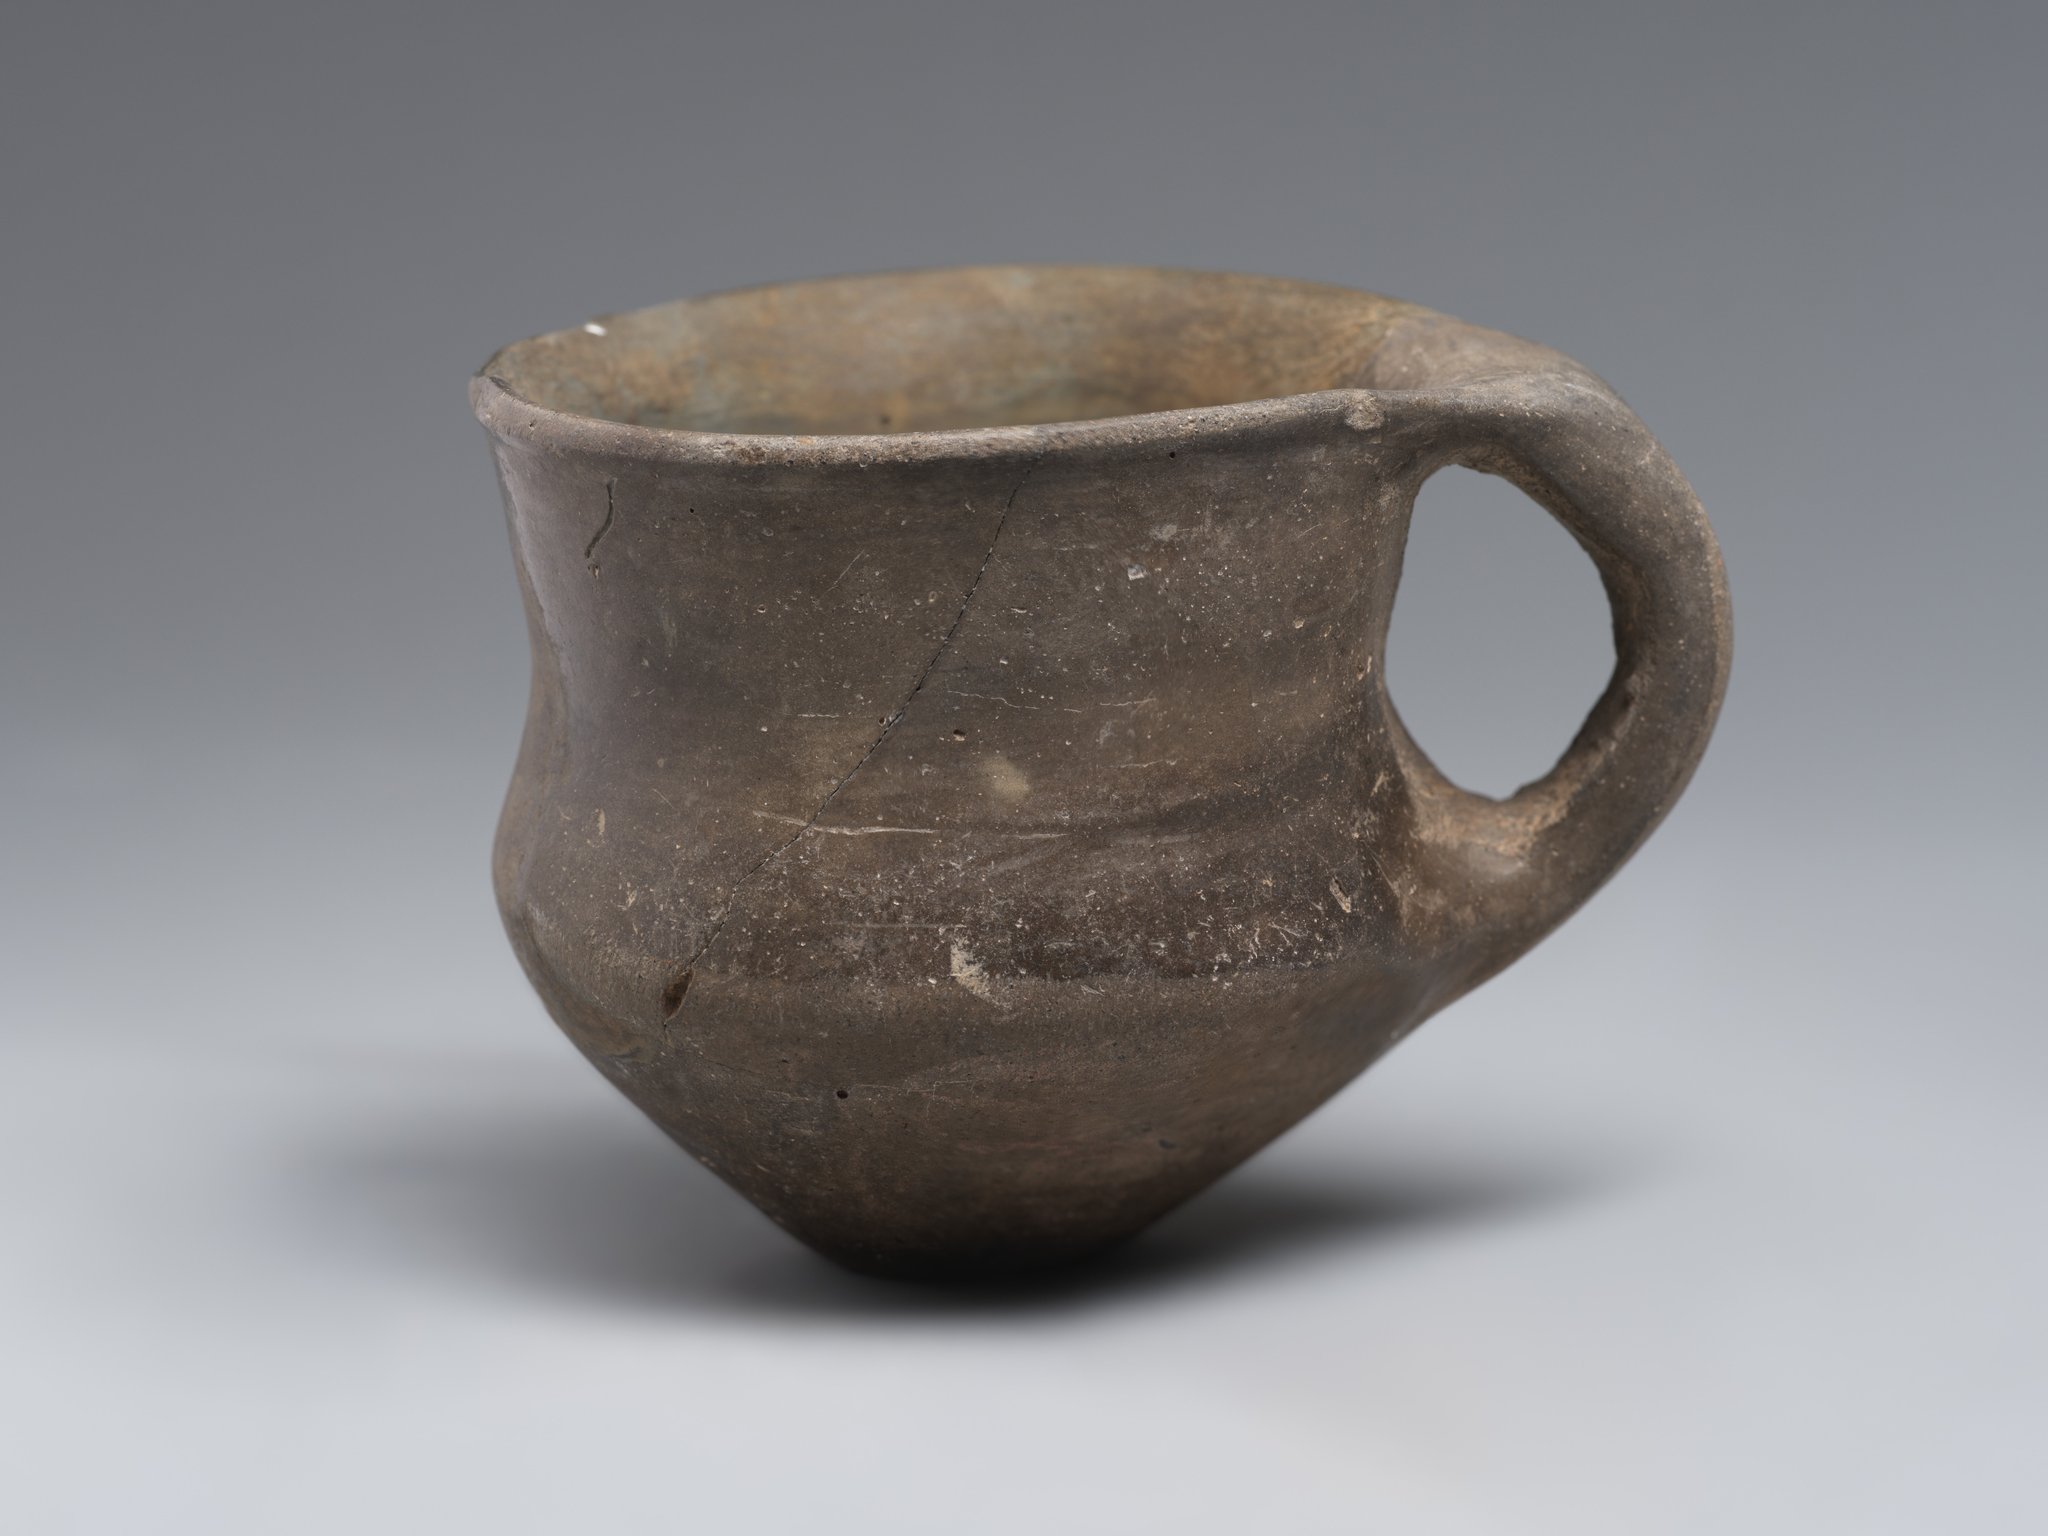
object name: cup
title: Strainer cup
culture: iranian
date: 900-801 BCE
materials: ceramic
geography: iran